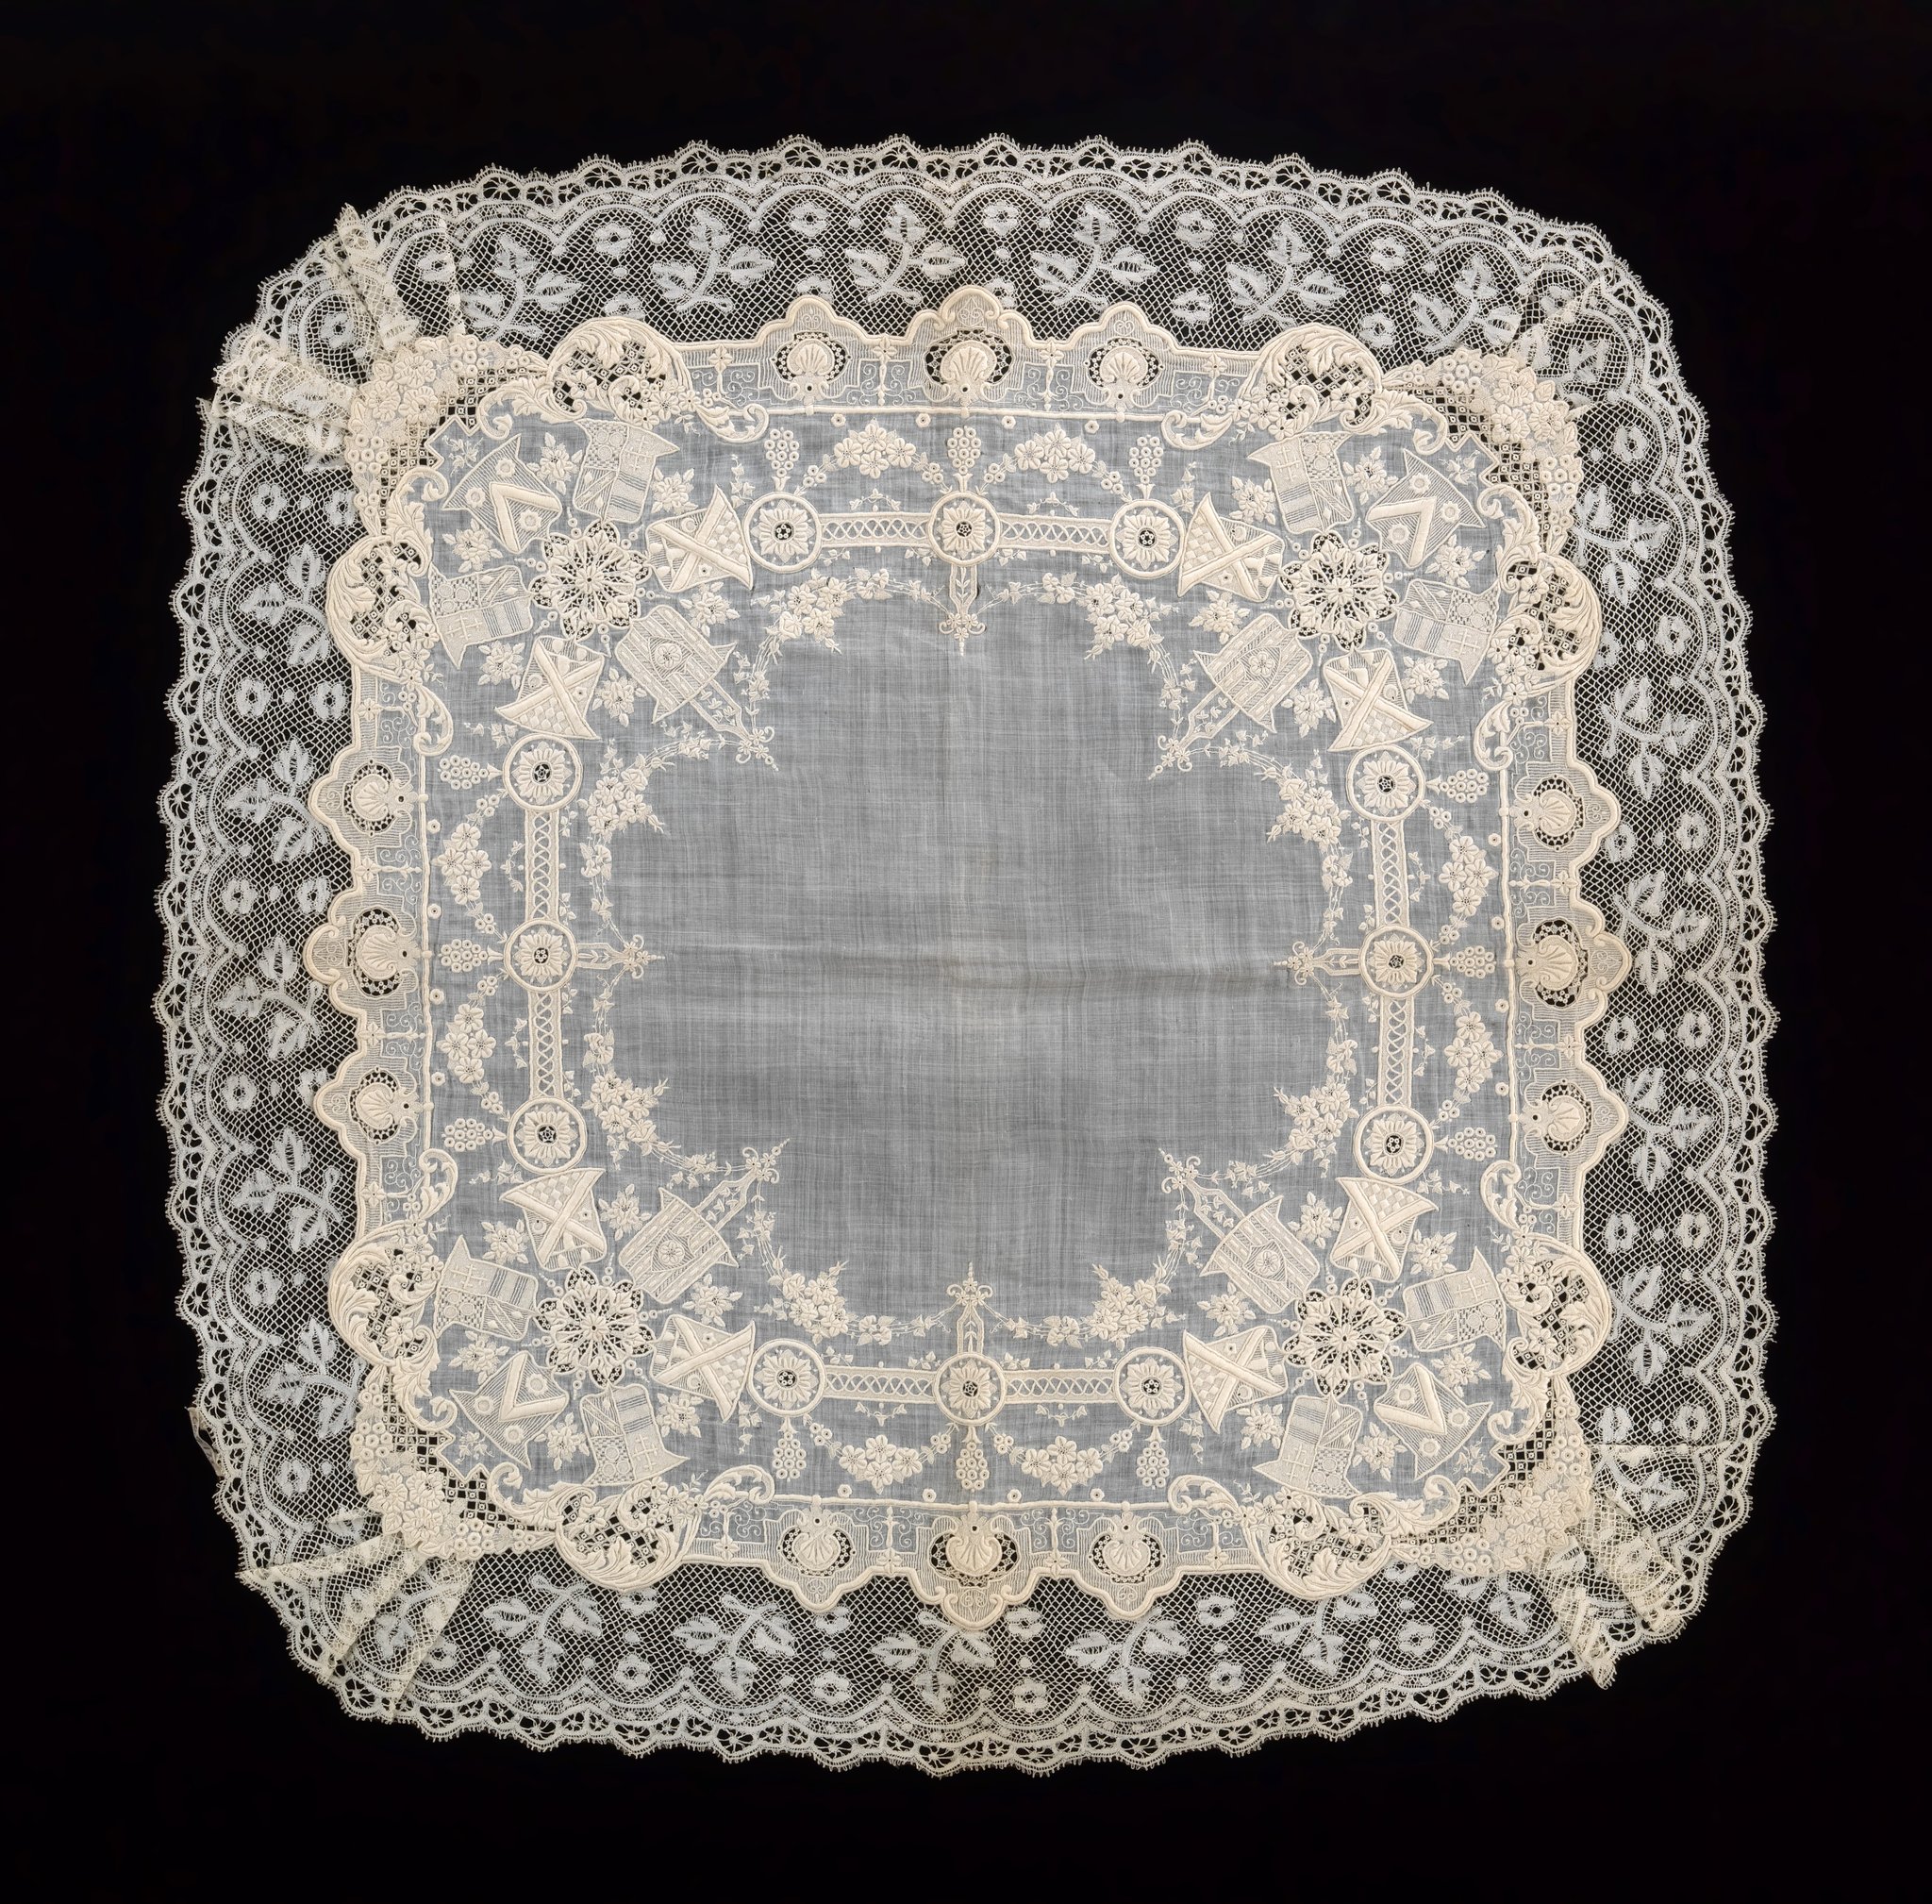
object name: handkerchief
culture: french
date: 1850-1870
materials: cotton, linen